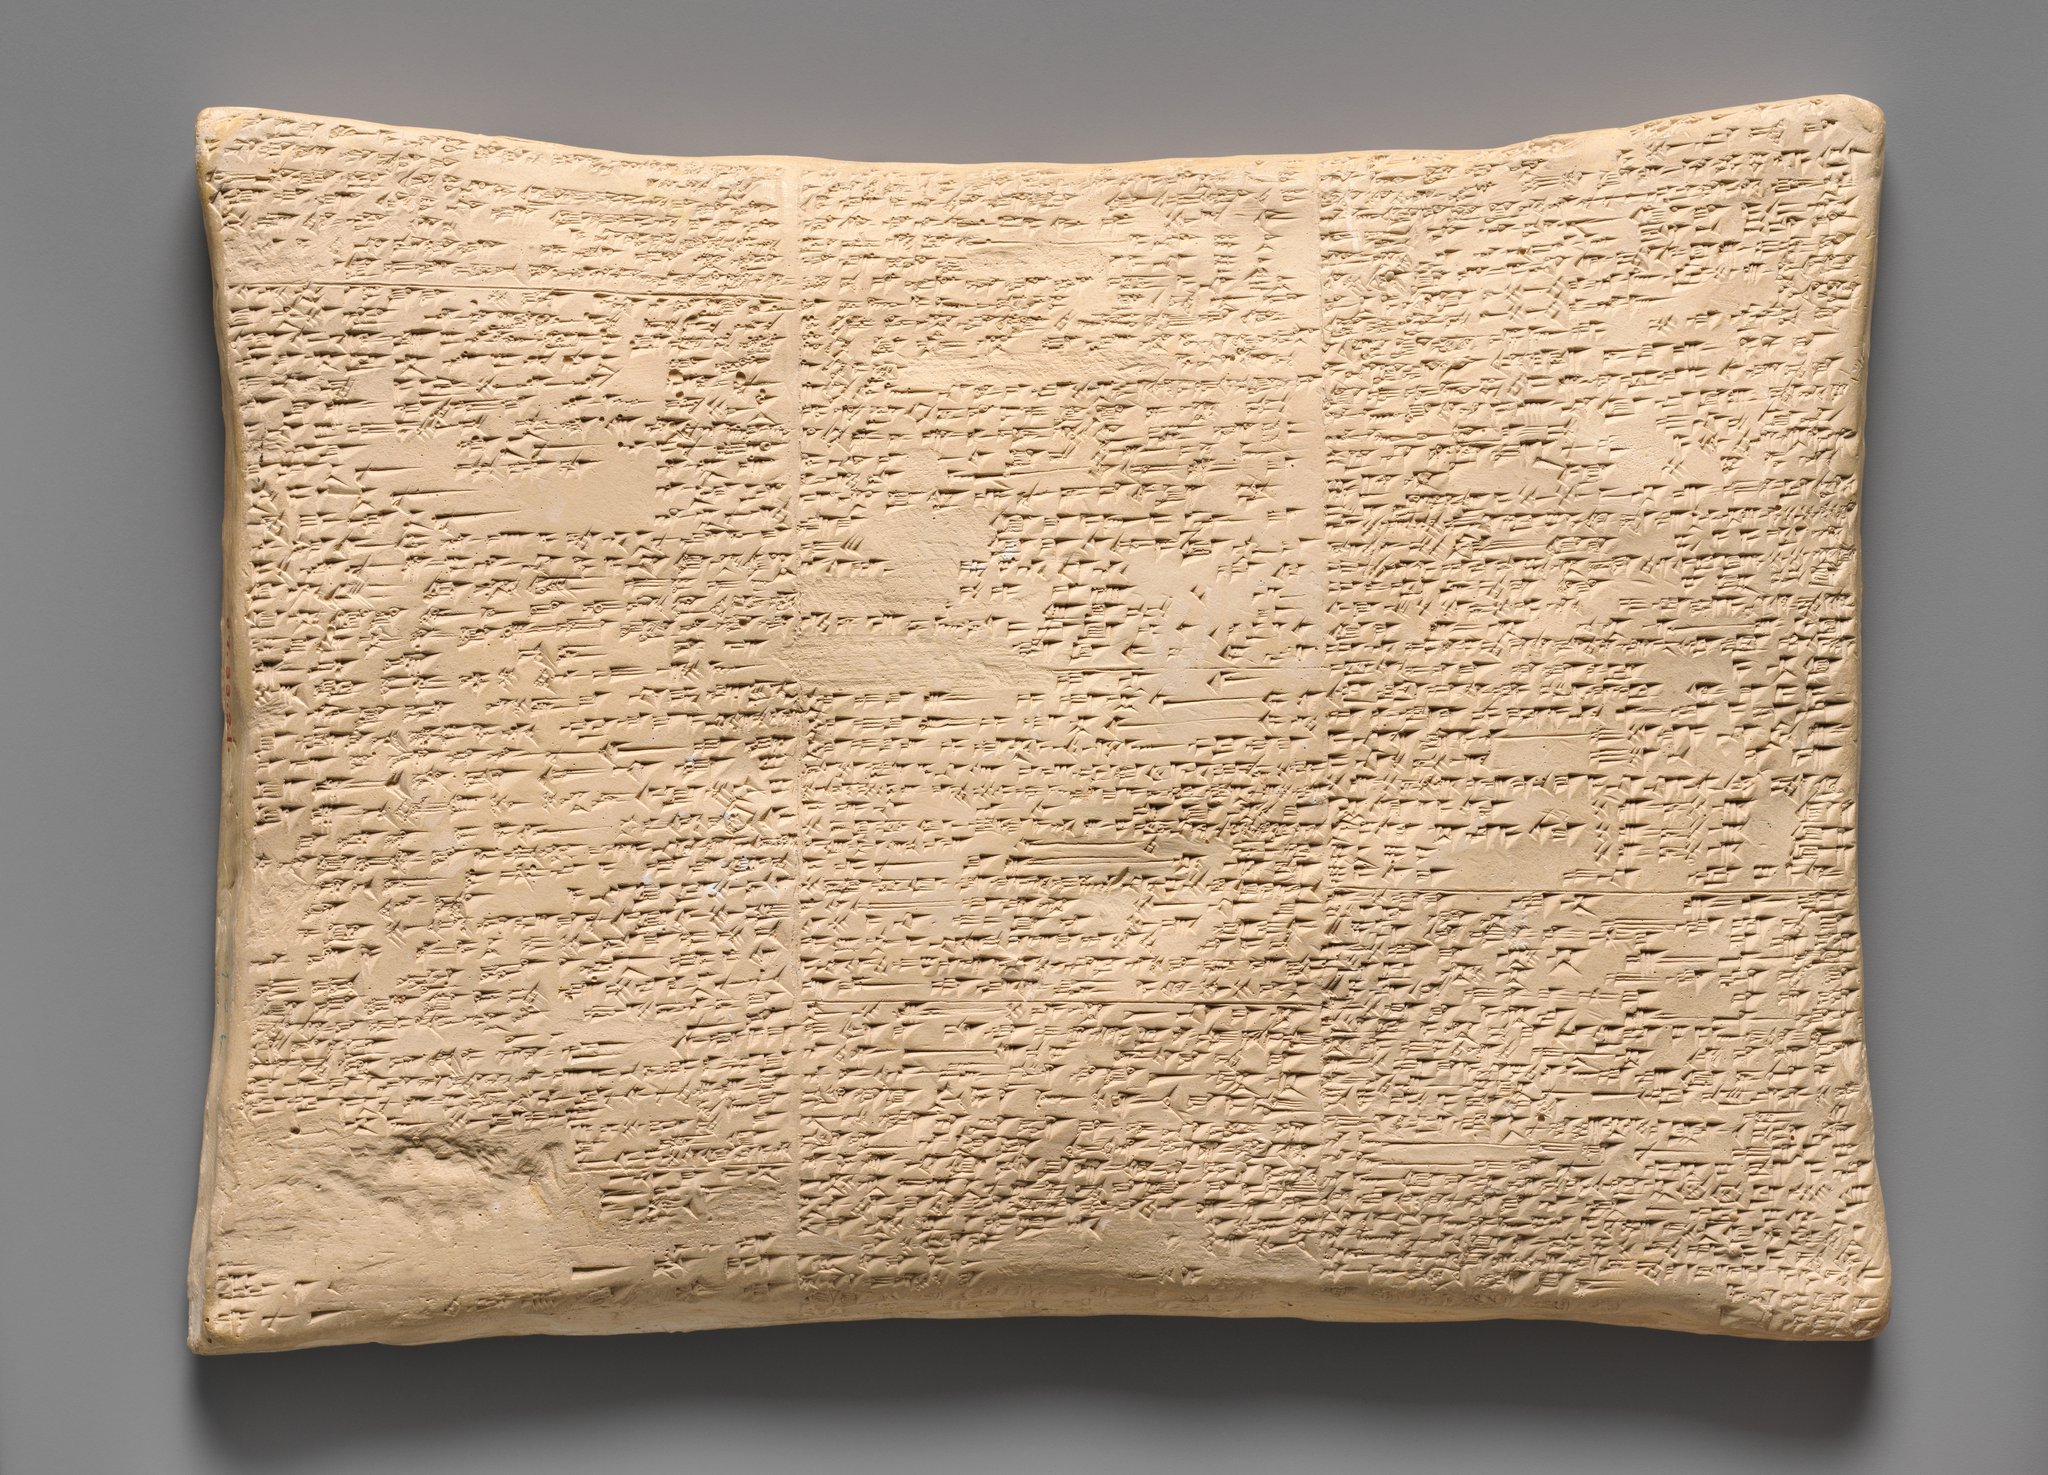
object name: cast of cuneiform tablet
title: Cast reconstruction of Babylonian Flood Tablet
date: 1801-1900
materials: plaster